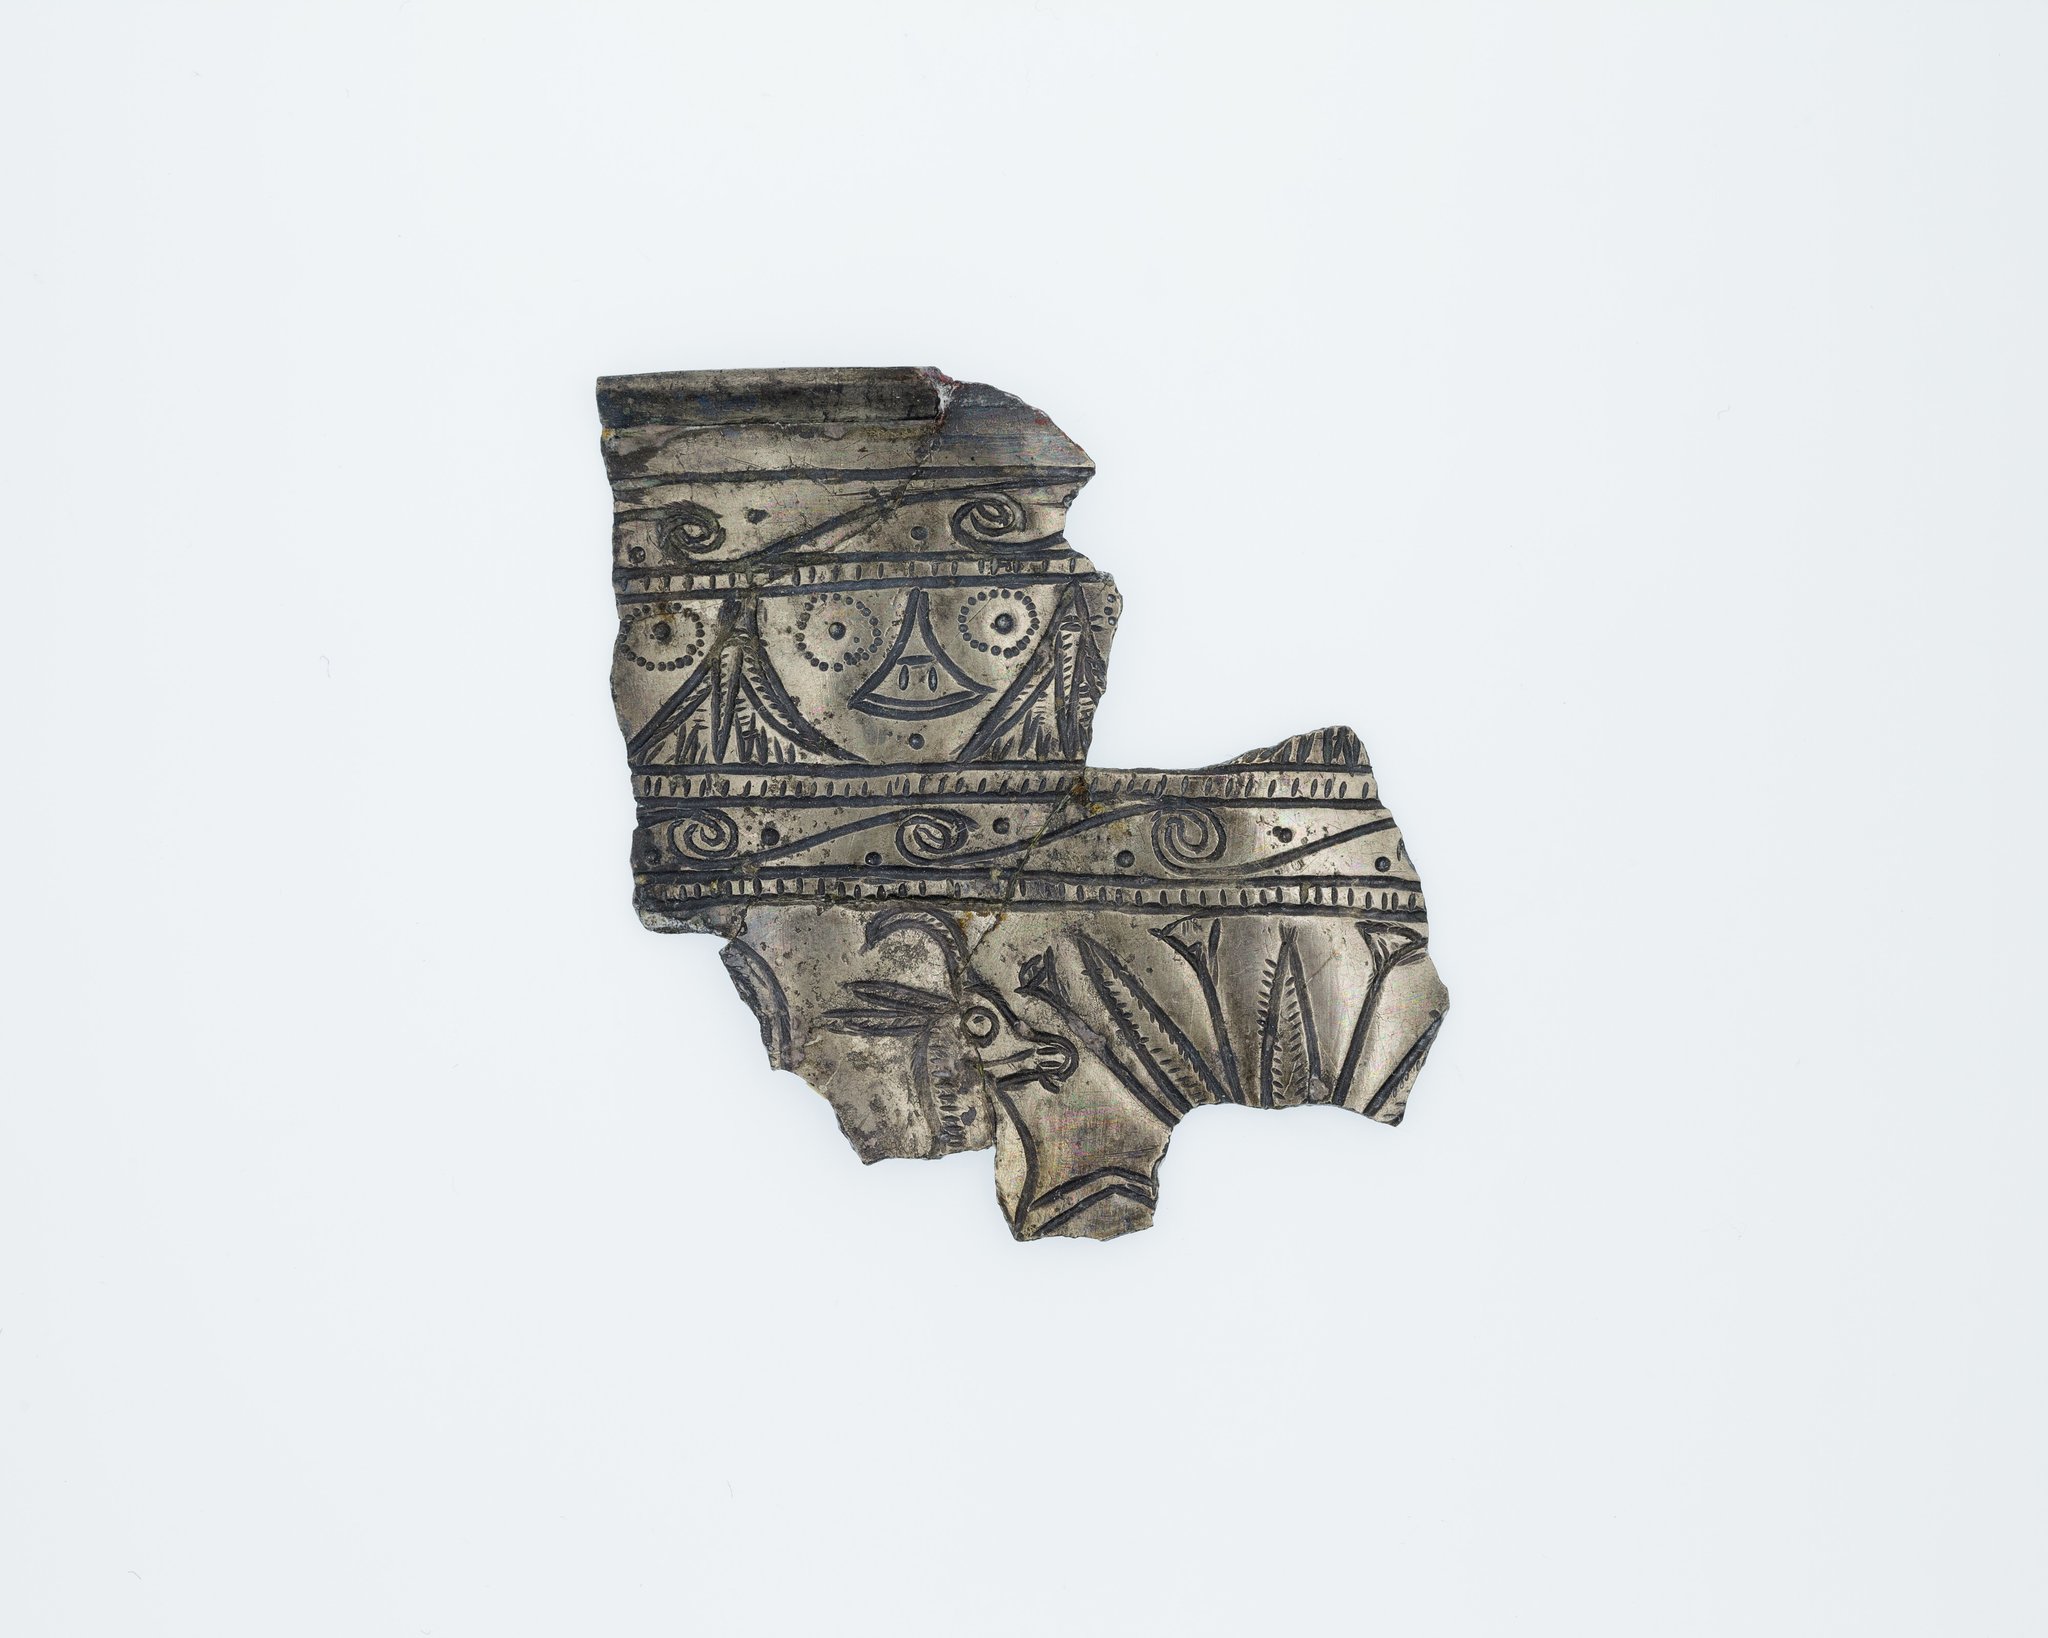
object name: strainer or vase fragment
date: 1295-1070 BCE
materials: silver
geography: egypt